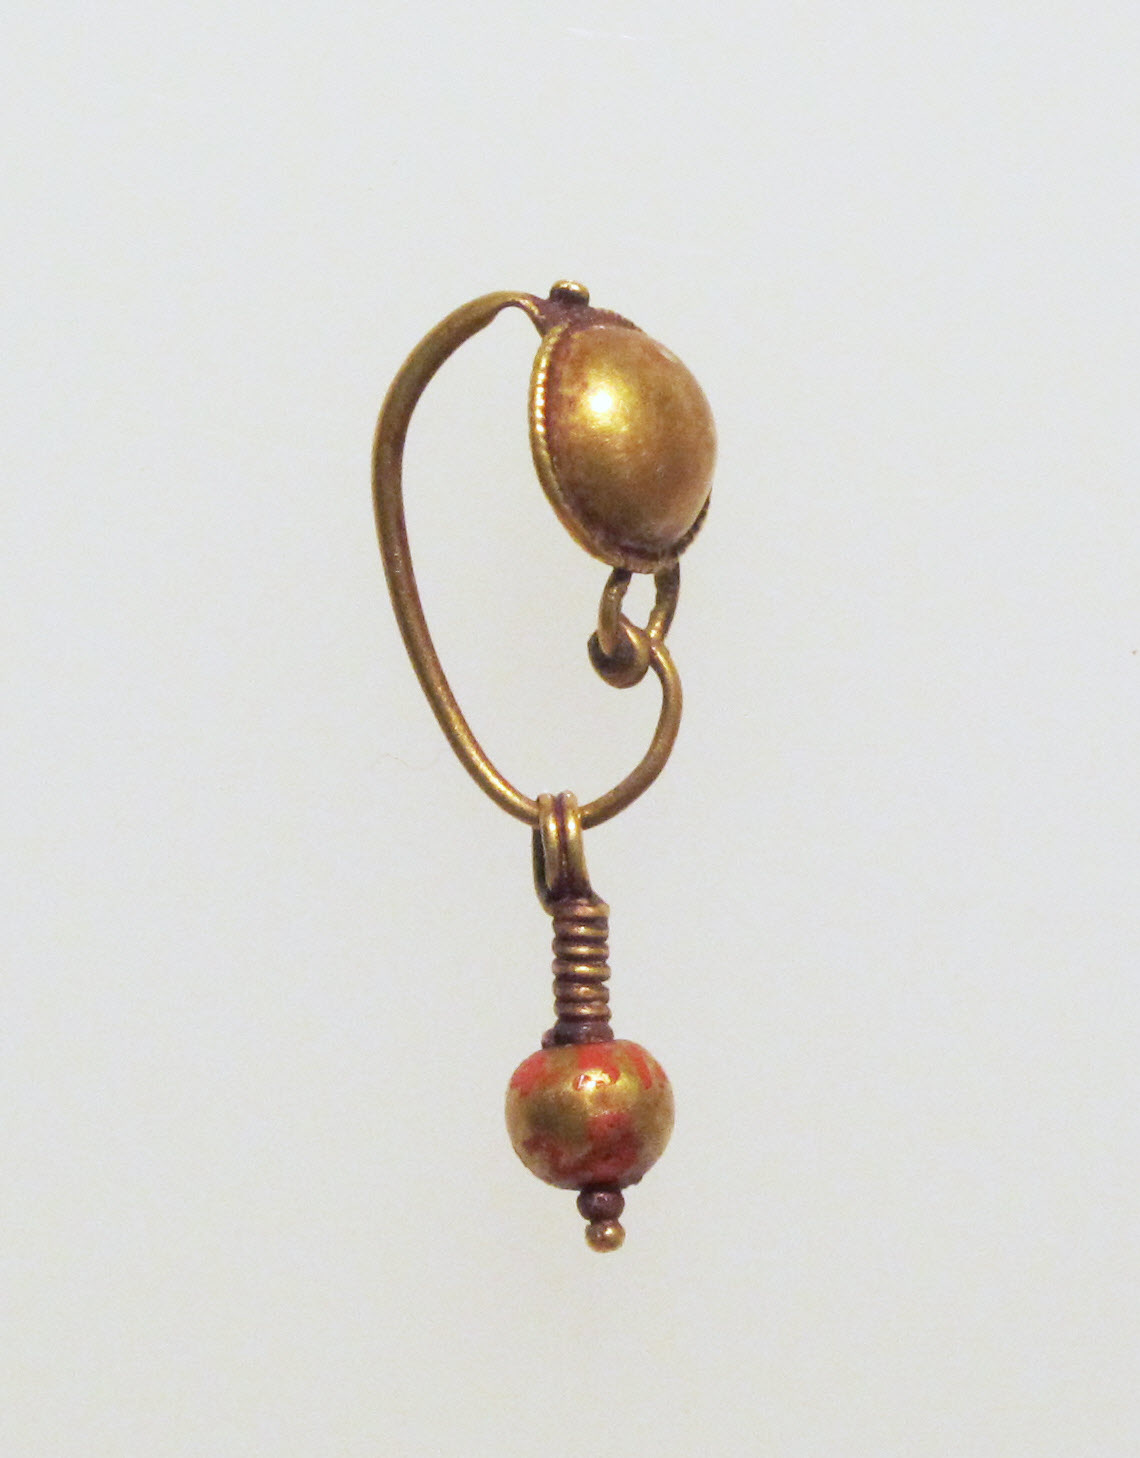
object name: earring with pendant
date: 7000 BCE-330 CE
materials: gold